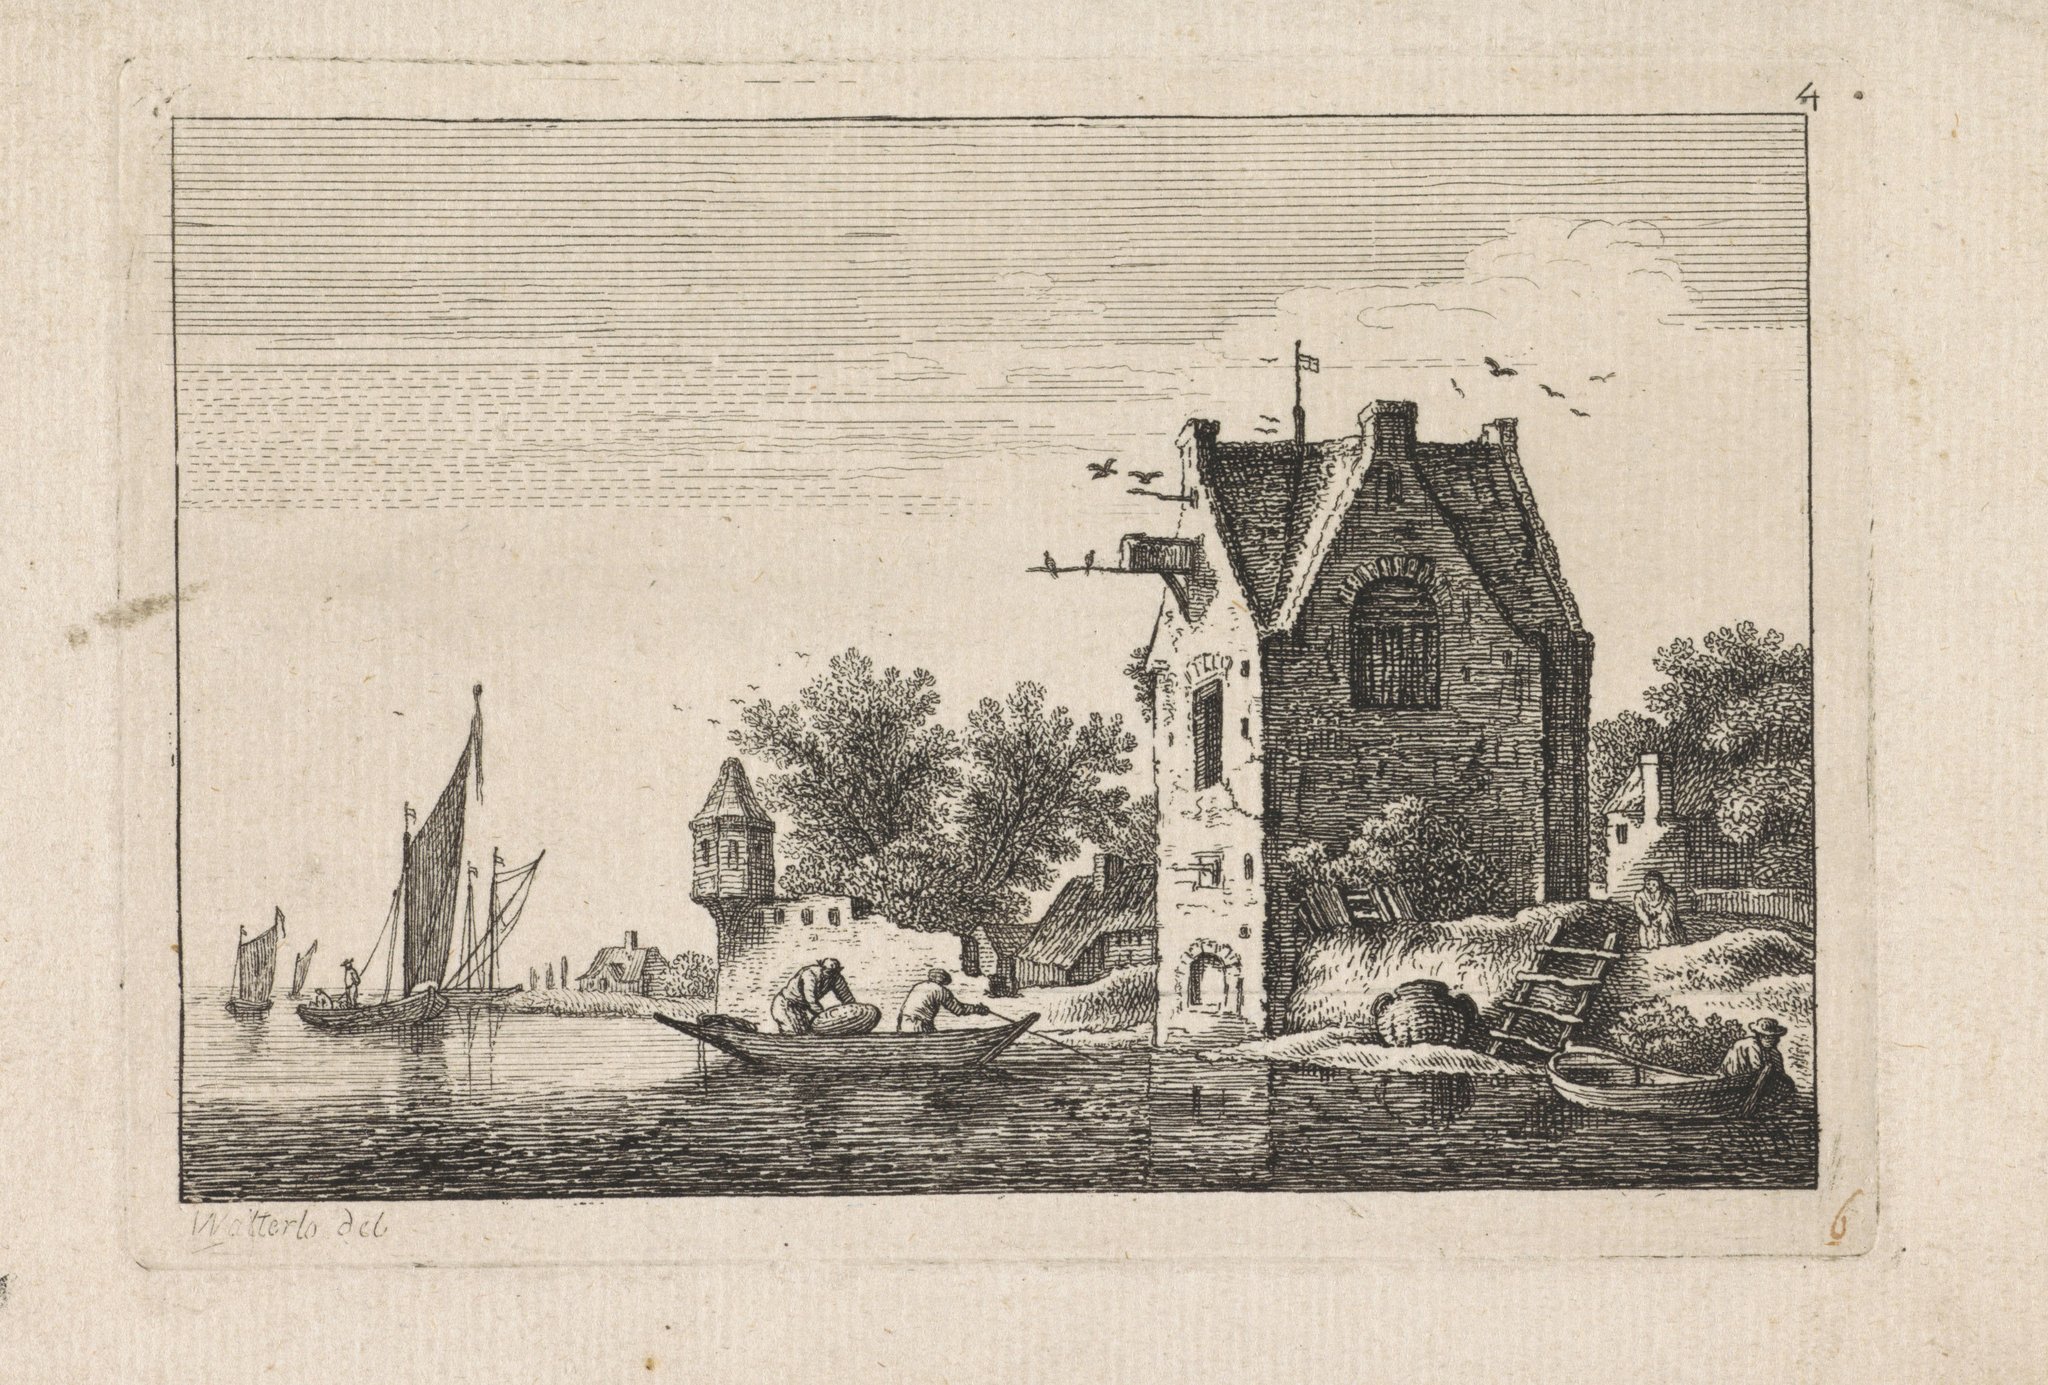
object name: print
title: Hoog gebouw aan het water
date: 1630-1663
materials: paper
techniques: etching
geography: amsterdam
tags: sentry box, sailing-ship, sailing-boat, landscapes with waters, waterscapes, seascapes (in the temperate zone), rowing-boat, canoe, etc., city-walls, landscapes (+ landscape with figures, staffage)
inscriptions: number: ‘6’, collector's mark: Lugt 2233, collector's mark: Lugt 2228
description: Een hoog gebouw ligt aan het water. Links van het gebouw ligt een deel van de stadsmuur met een wachthuisje. In het water verschillende boten.